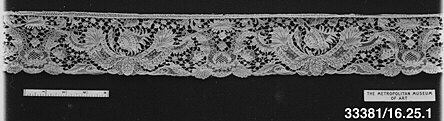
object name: fragment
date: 1801-1900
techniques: lace